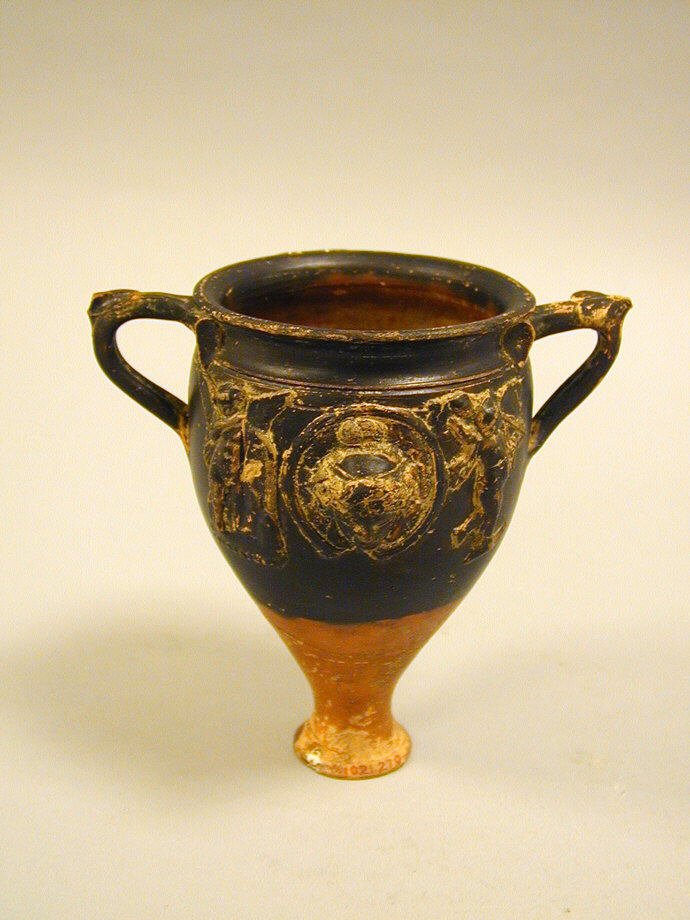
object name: cup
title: Terracotta cup with appliqués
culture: greek, pergamene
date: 150-100 BCE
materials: terracotta